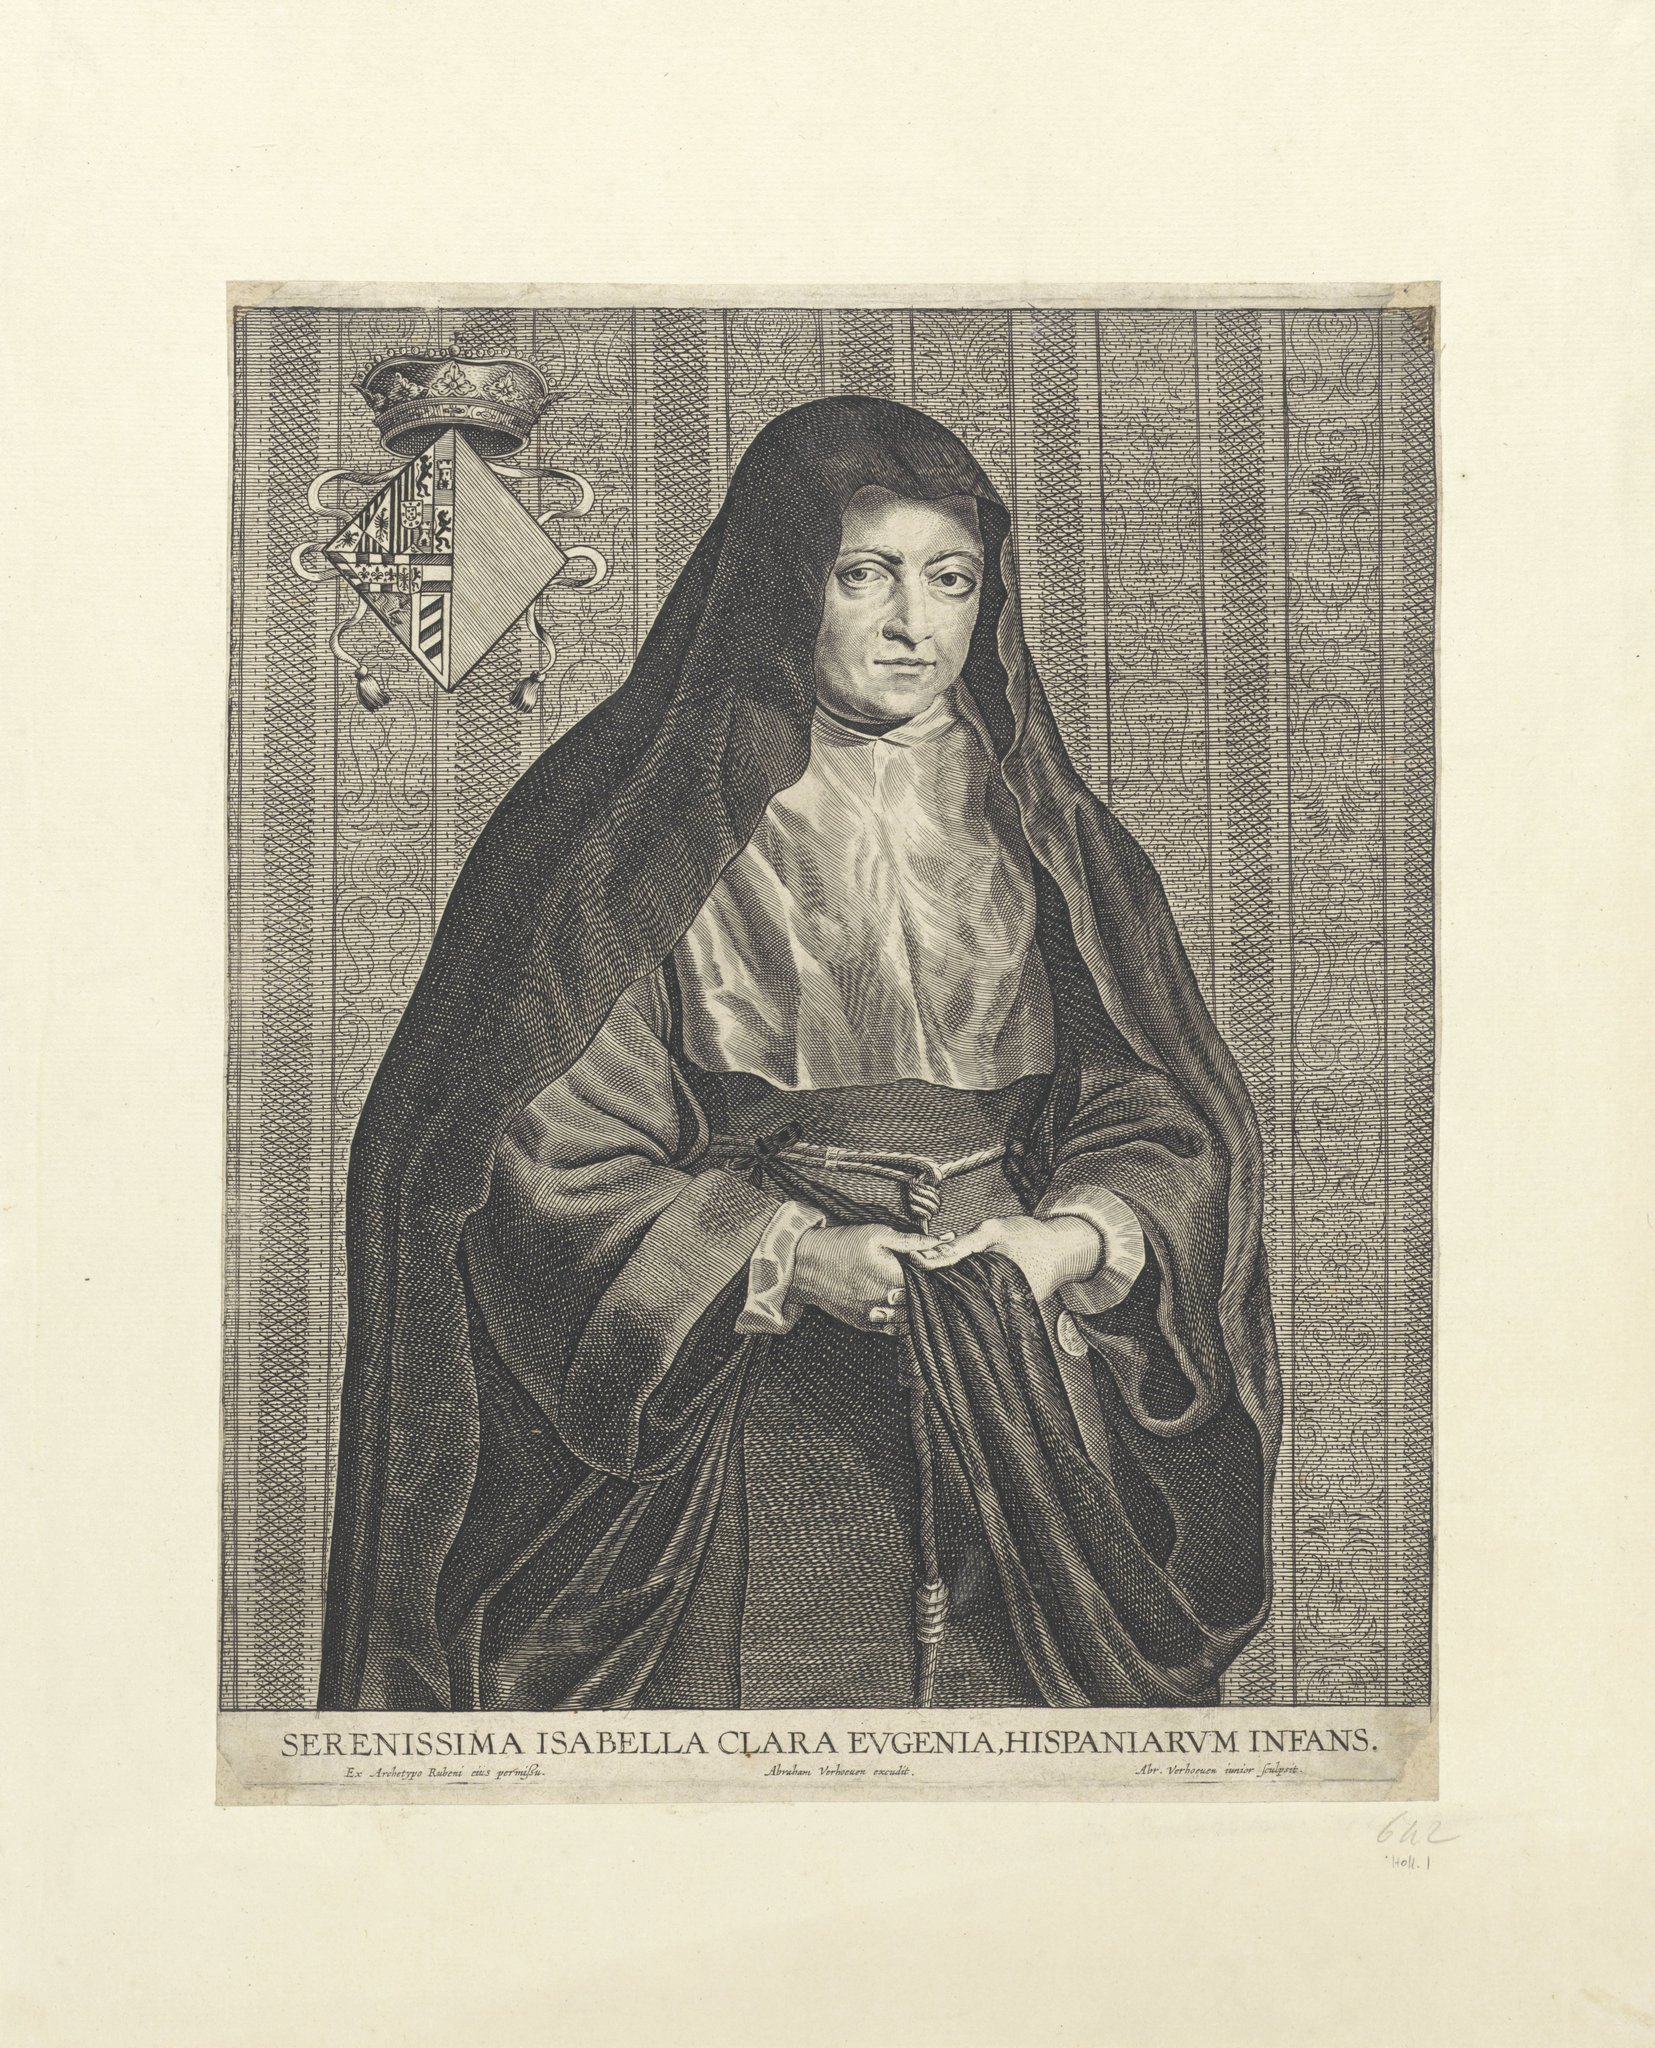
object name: print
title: Portret van Isabella Clara Eugenia, Infanta van Spanje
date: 1615-1652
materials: paper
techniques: engraving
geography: antwerp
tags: infante van spanje isabella clara eugenia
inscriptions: collector's mark: Lugt 240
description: Portret van Isabella Clara Eugenia, Infanta van Spanje, als non uit de orde der Clarissen.